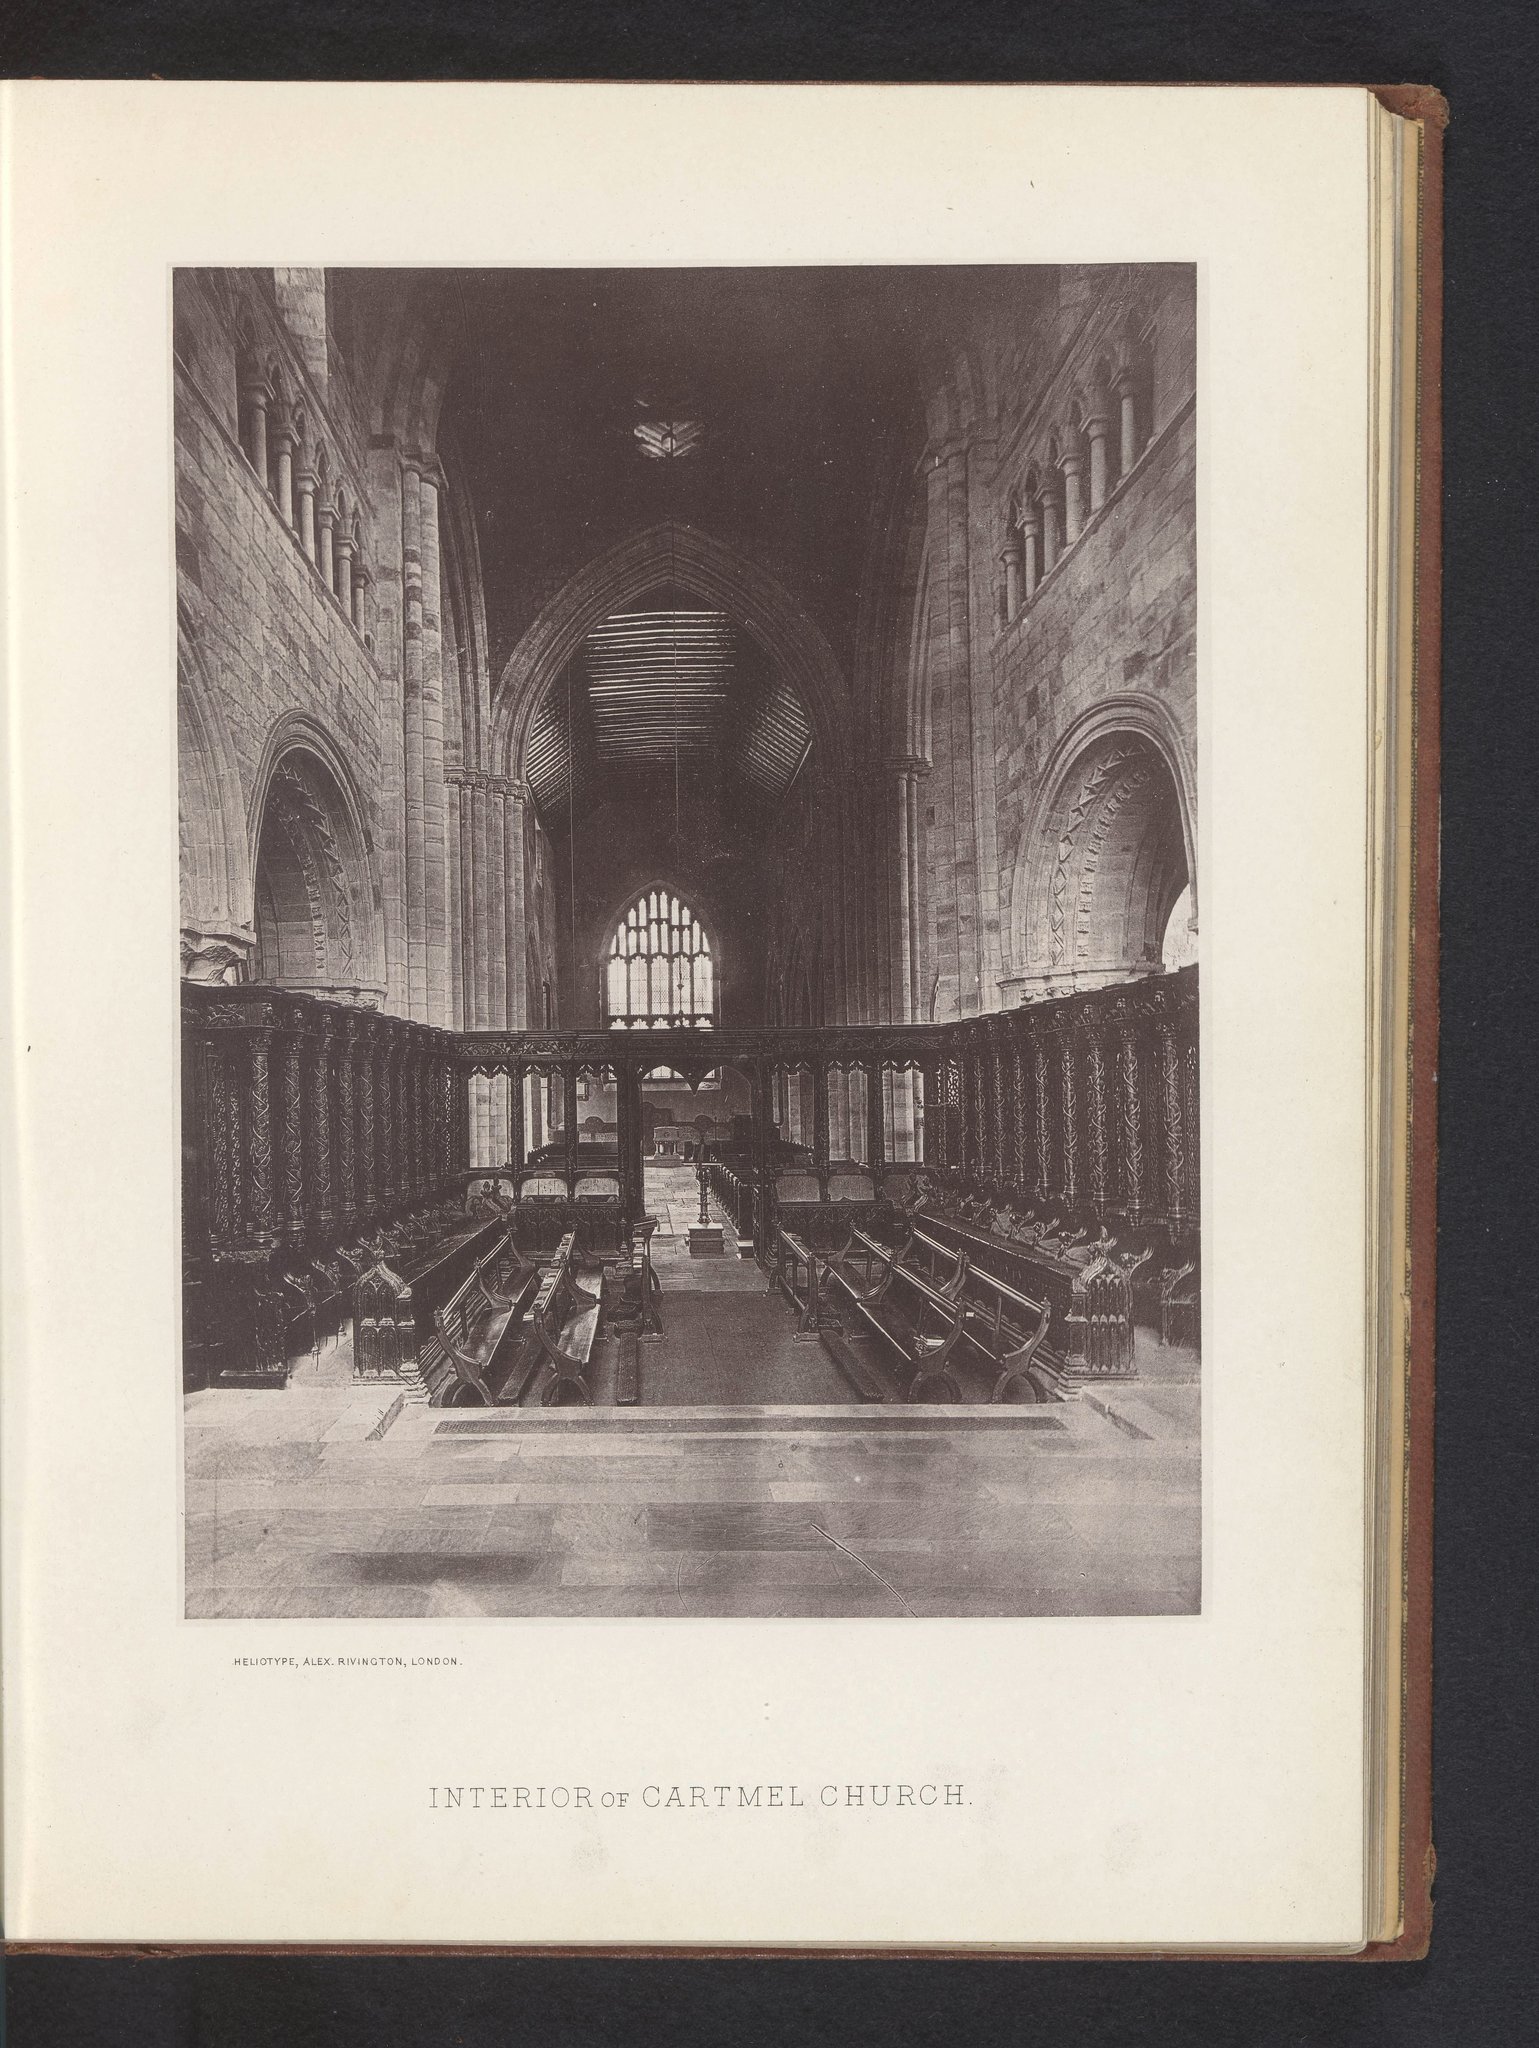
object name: photomechanical print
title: Interior of Cartmel church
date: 1870-1880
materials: paper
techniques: heliotype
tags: interior of church, seats of the clergy, choir-stalls